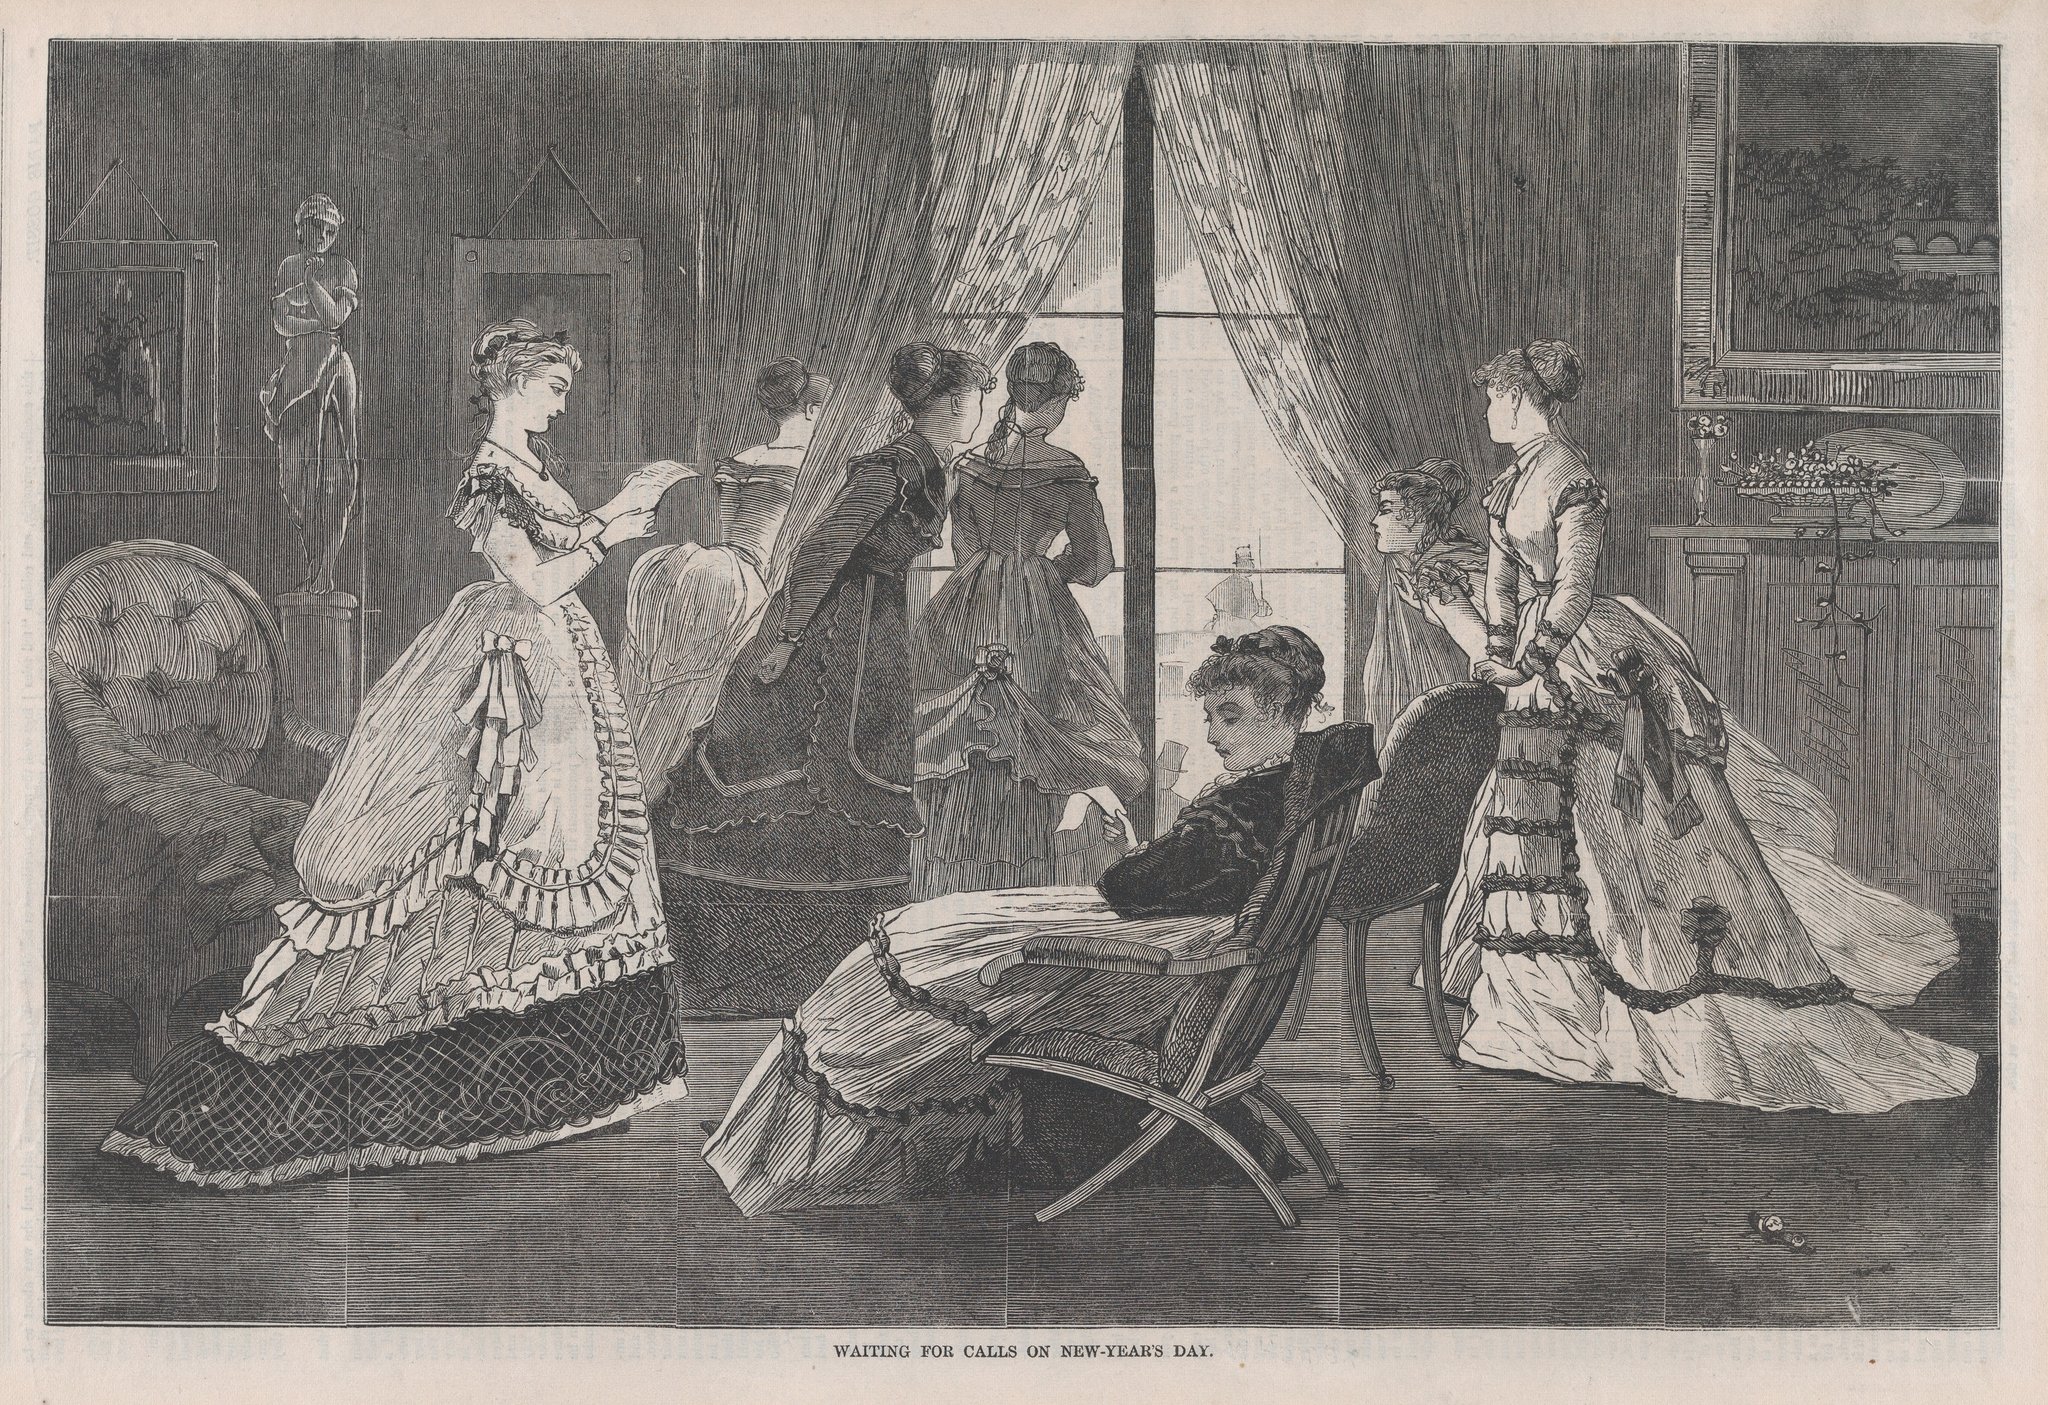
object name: print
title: Waiting for Calls on New Year's Day (from "Harper's Bazar," Vol. II)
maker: winslow homer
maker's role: artist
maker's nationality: american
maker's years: 1836-1910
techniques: engraving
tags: interiors,women